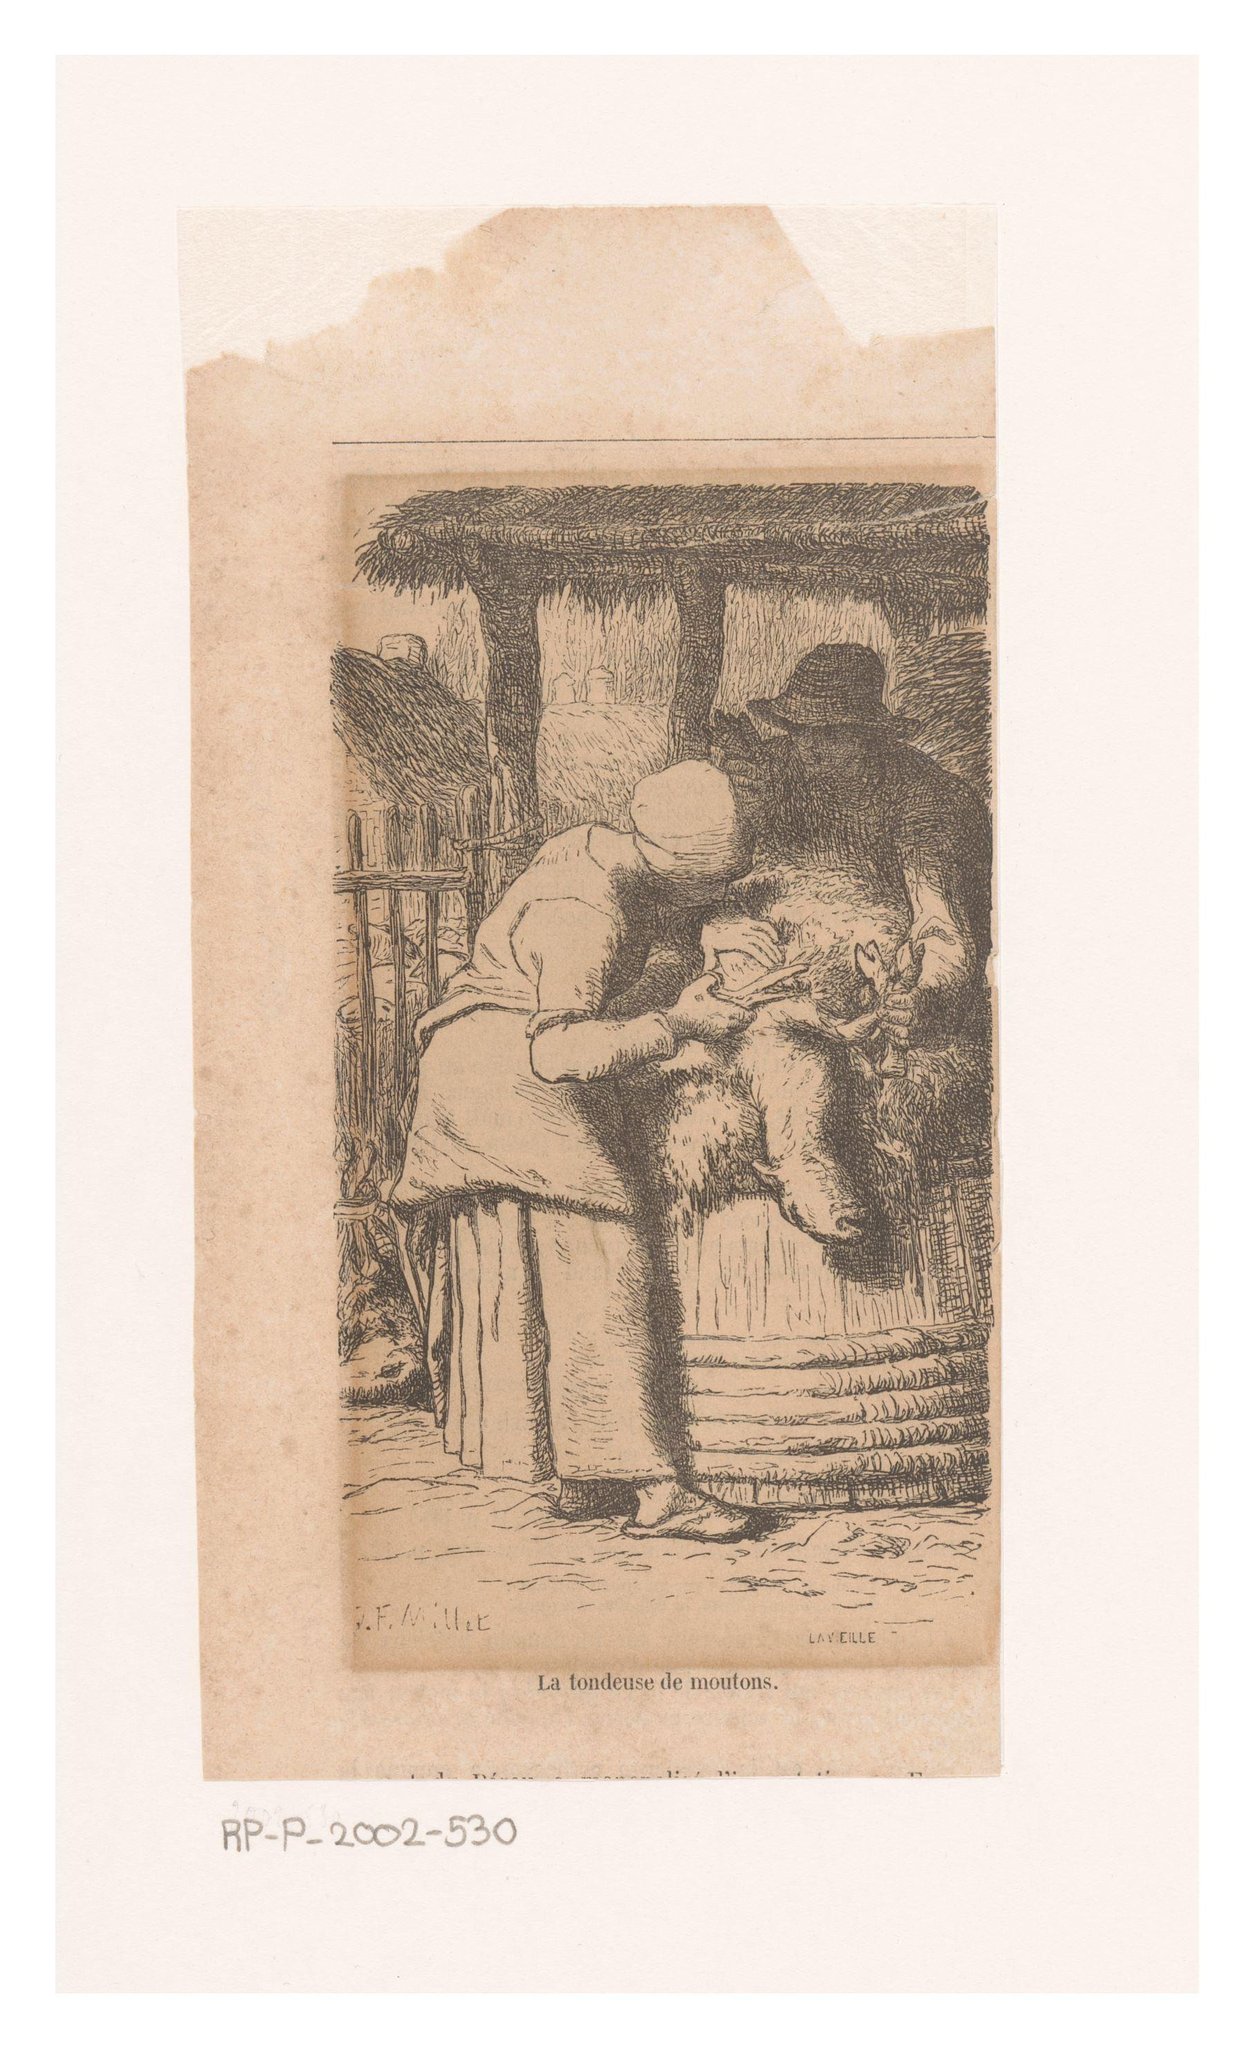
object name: print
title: Boerenwerk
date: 1853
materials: paper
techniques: letterpress printing, engraving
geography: paris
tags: crafts and industries (+ agricultural processes), shearing (sheep)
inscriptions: collector's mark: Lugt 2228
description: Prent maakt deel uit van een serie van tien houtgravures gepubliceerd in 'L'Illustration' van 5 februari 1853, bij het artikel Revue Agricole van Saint-Germain Leduc.